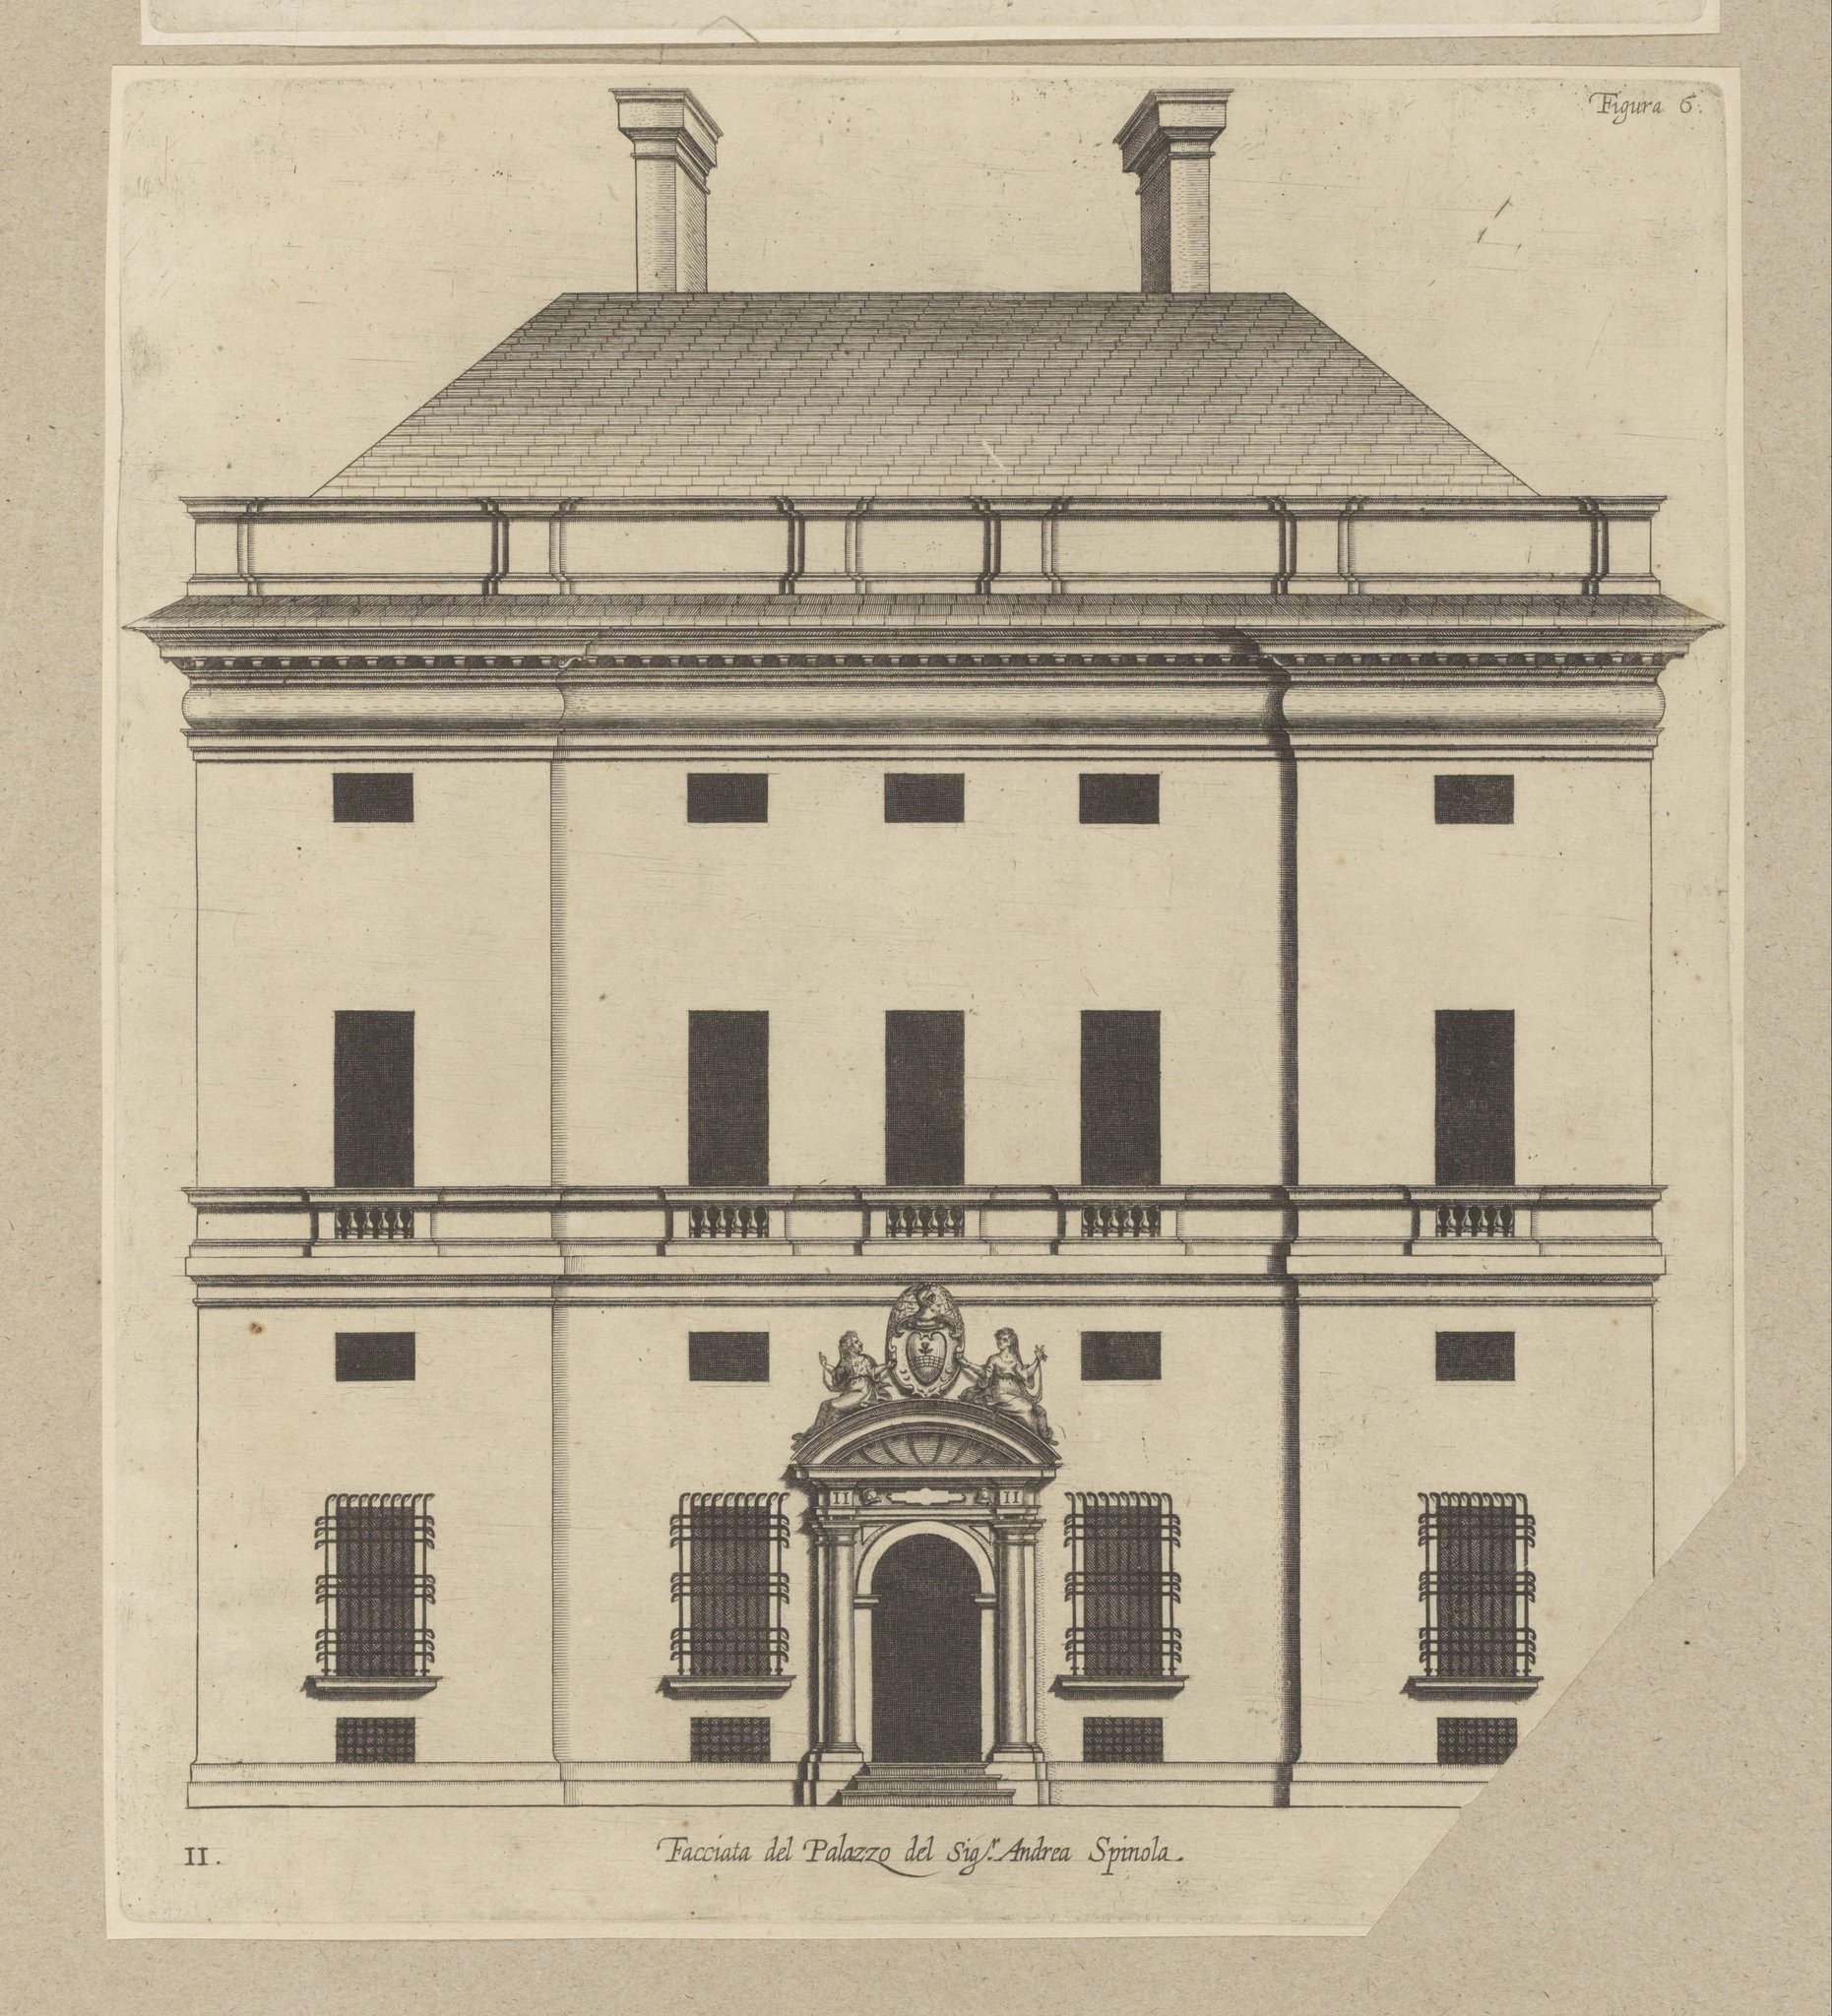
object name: album leaf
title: Opstand van de façade van het Palazzo Gambaro te Genua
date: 1622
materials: paper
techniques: engraving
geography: antwerp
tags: hôtel, i.e. small palace in city, façade (of house or building), exterior ~ architectural design or model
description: Deze prent maakt deel uit van een album.